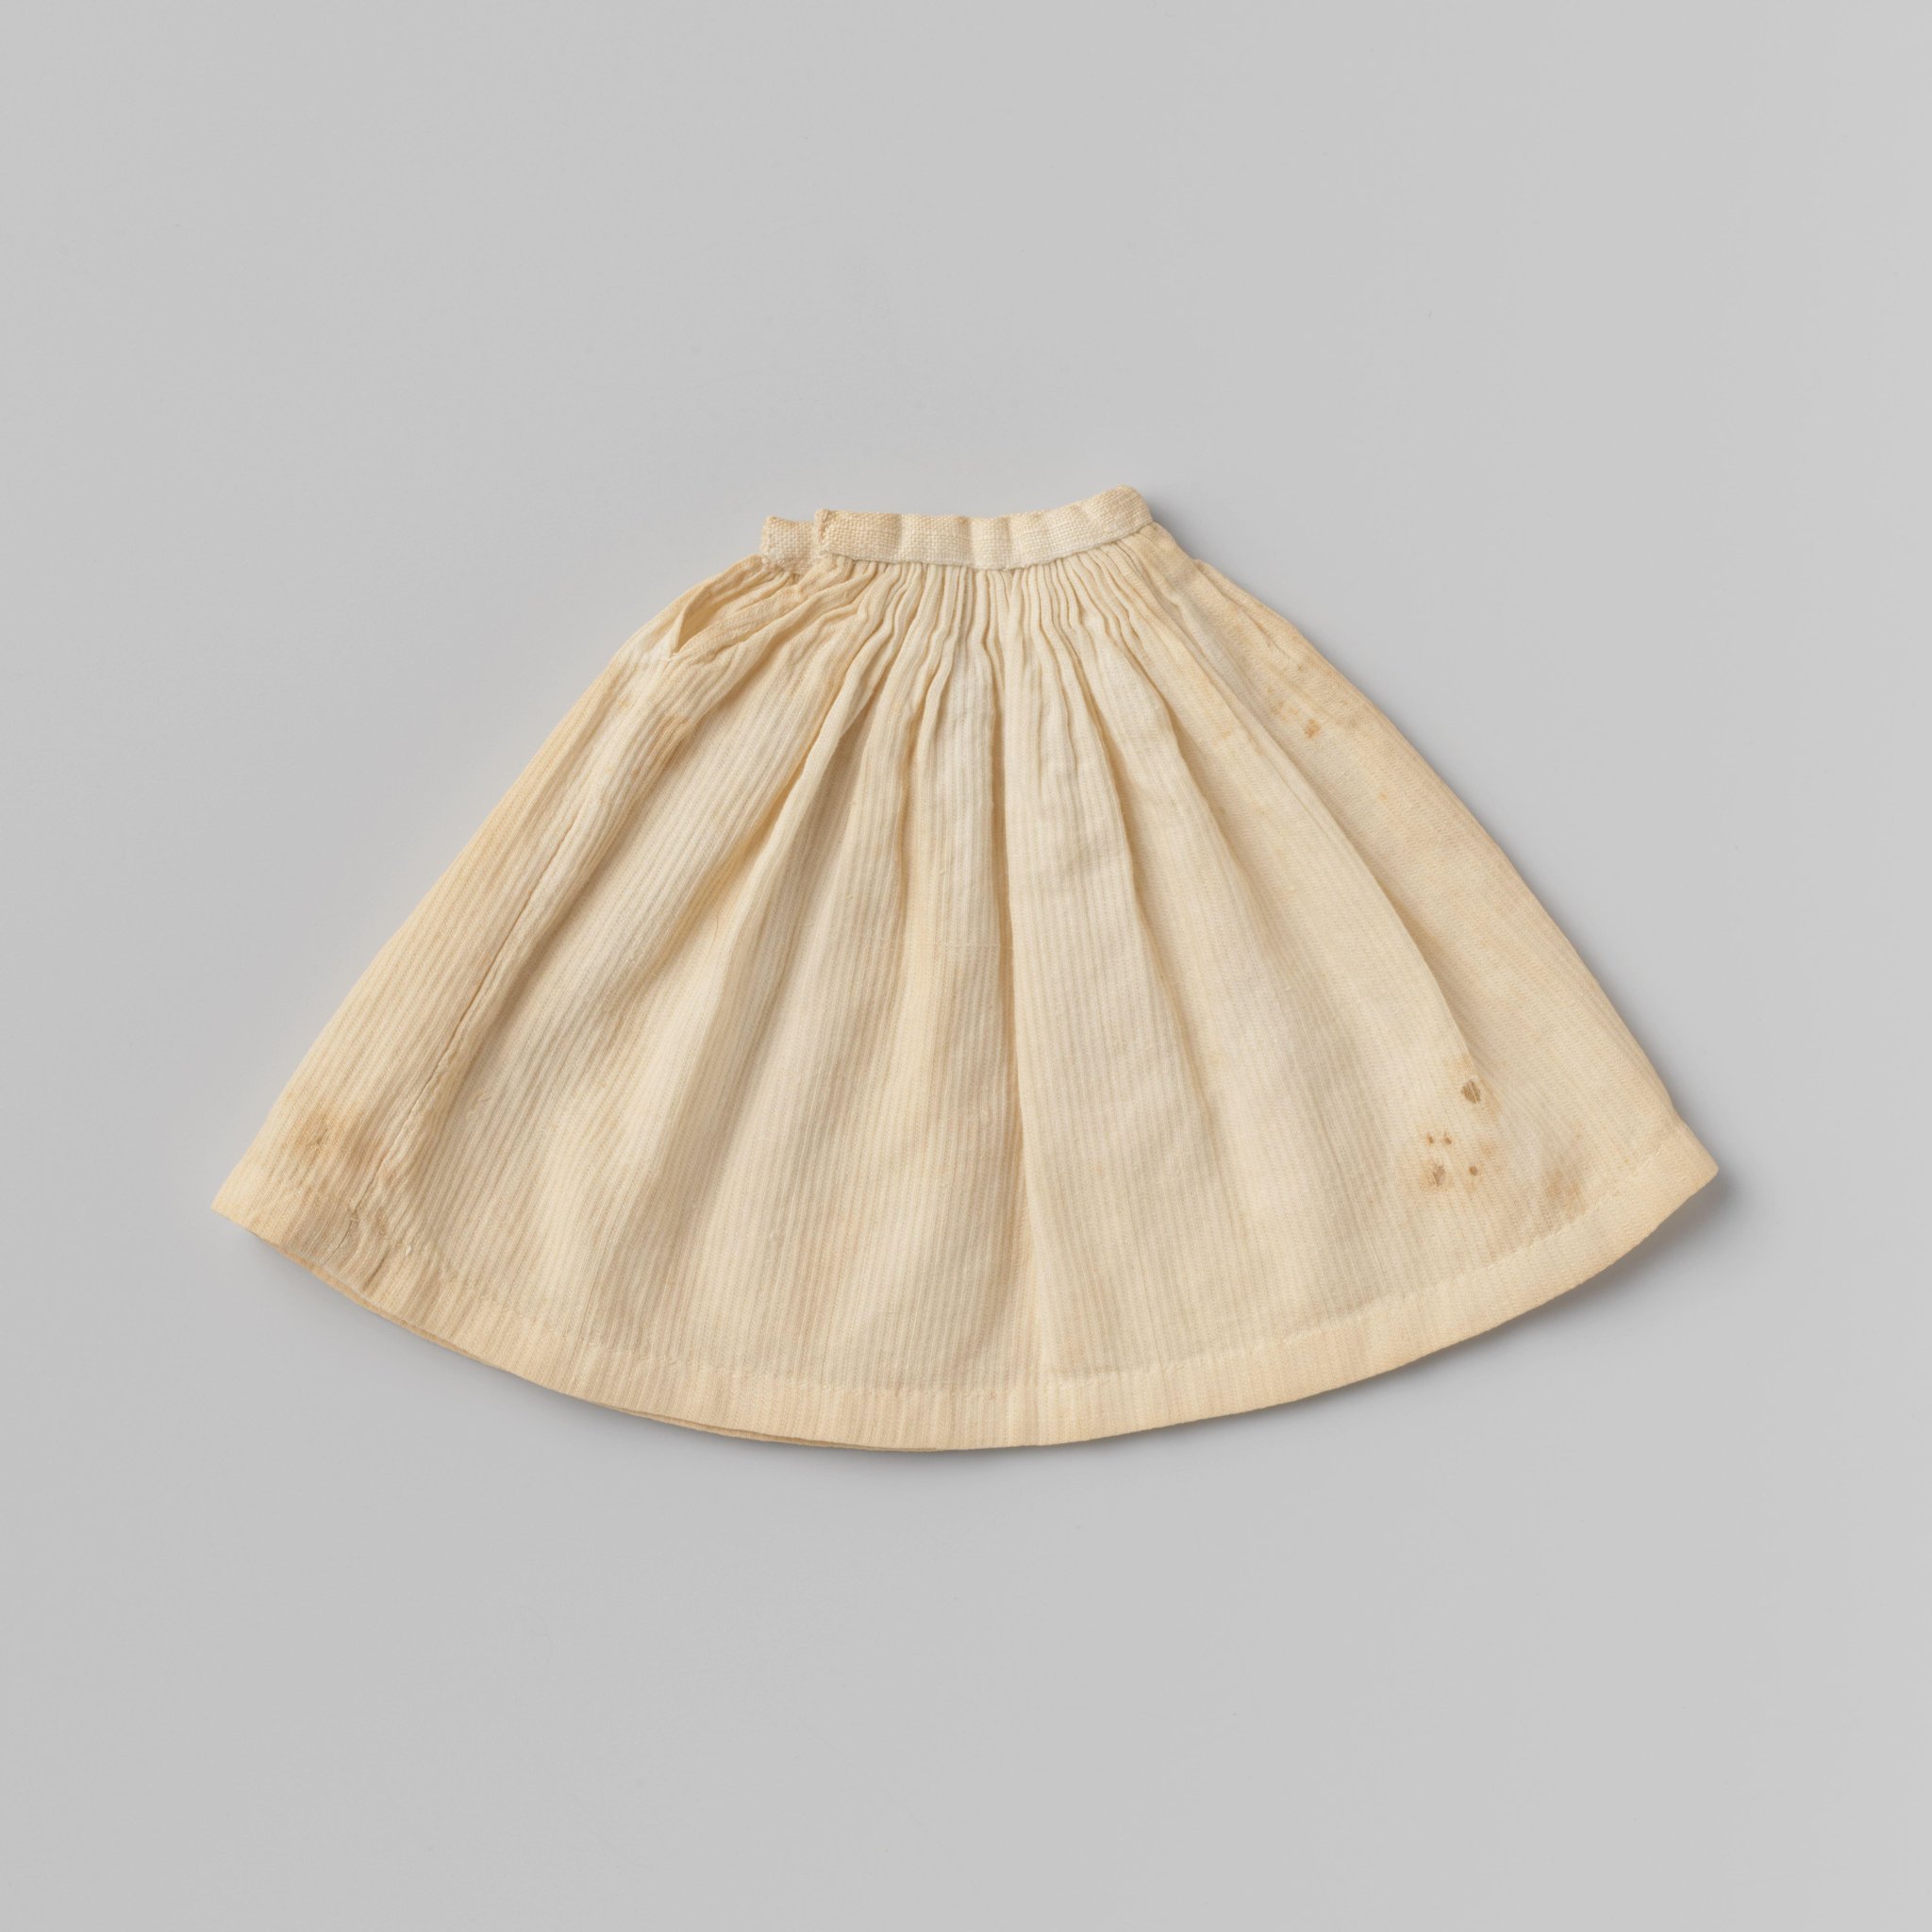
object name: underskirt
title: Onderrok met streepmotief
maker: Anonymous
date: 1750-1800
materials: cotton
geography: netherlands